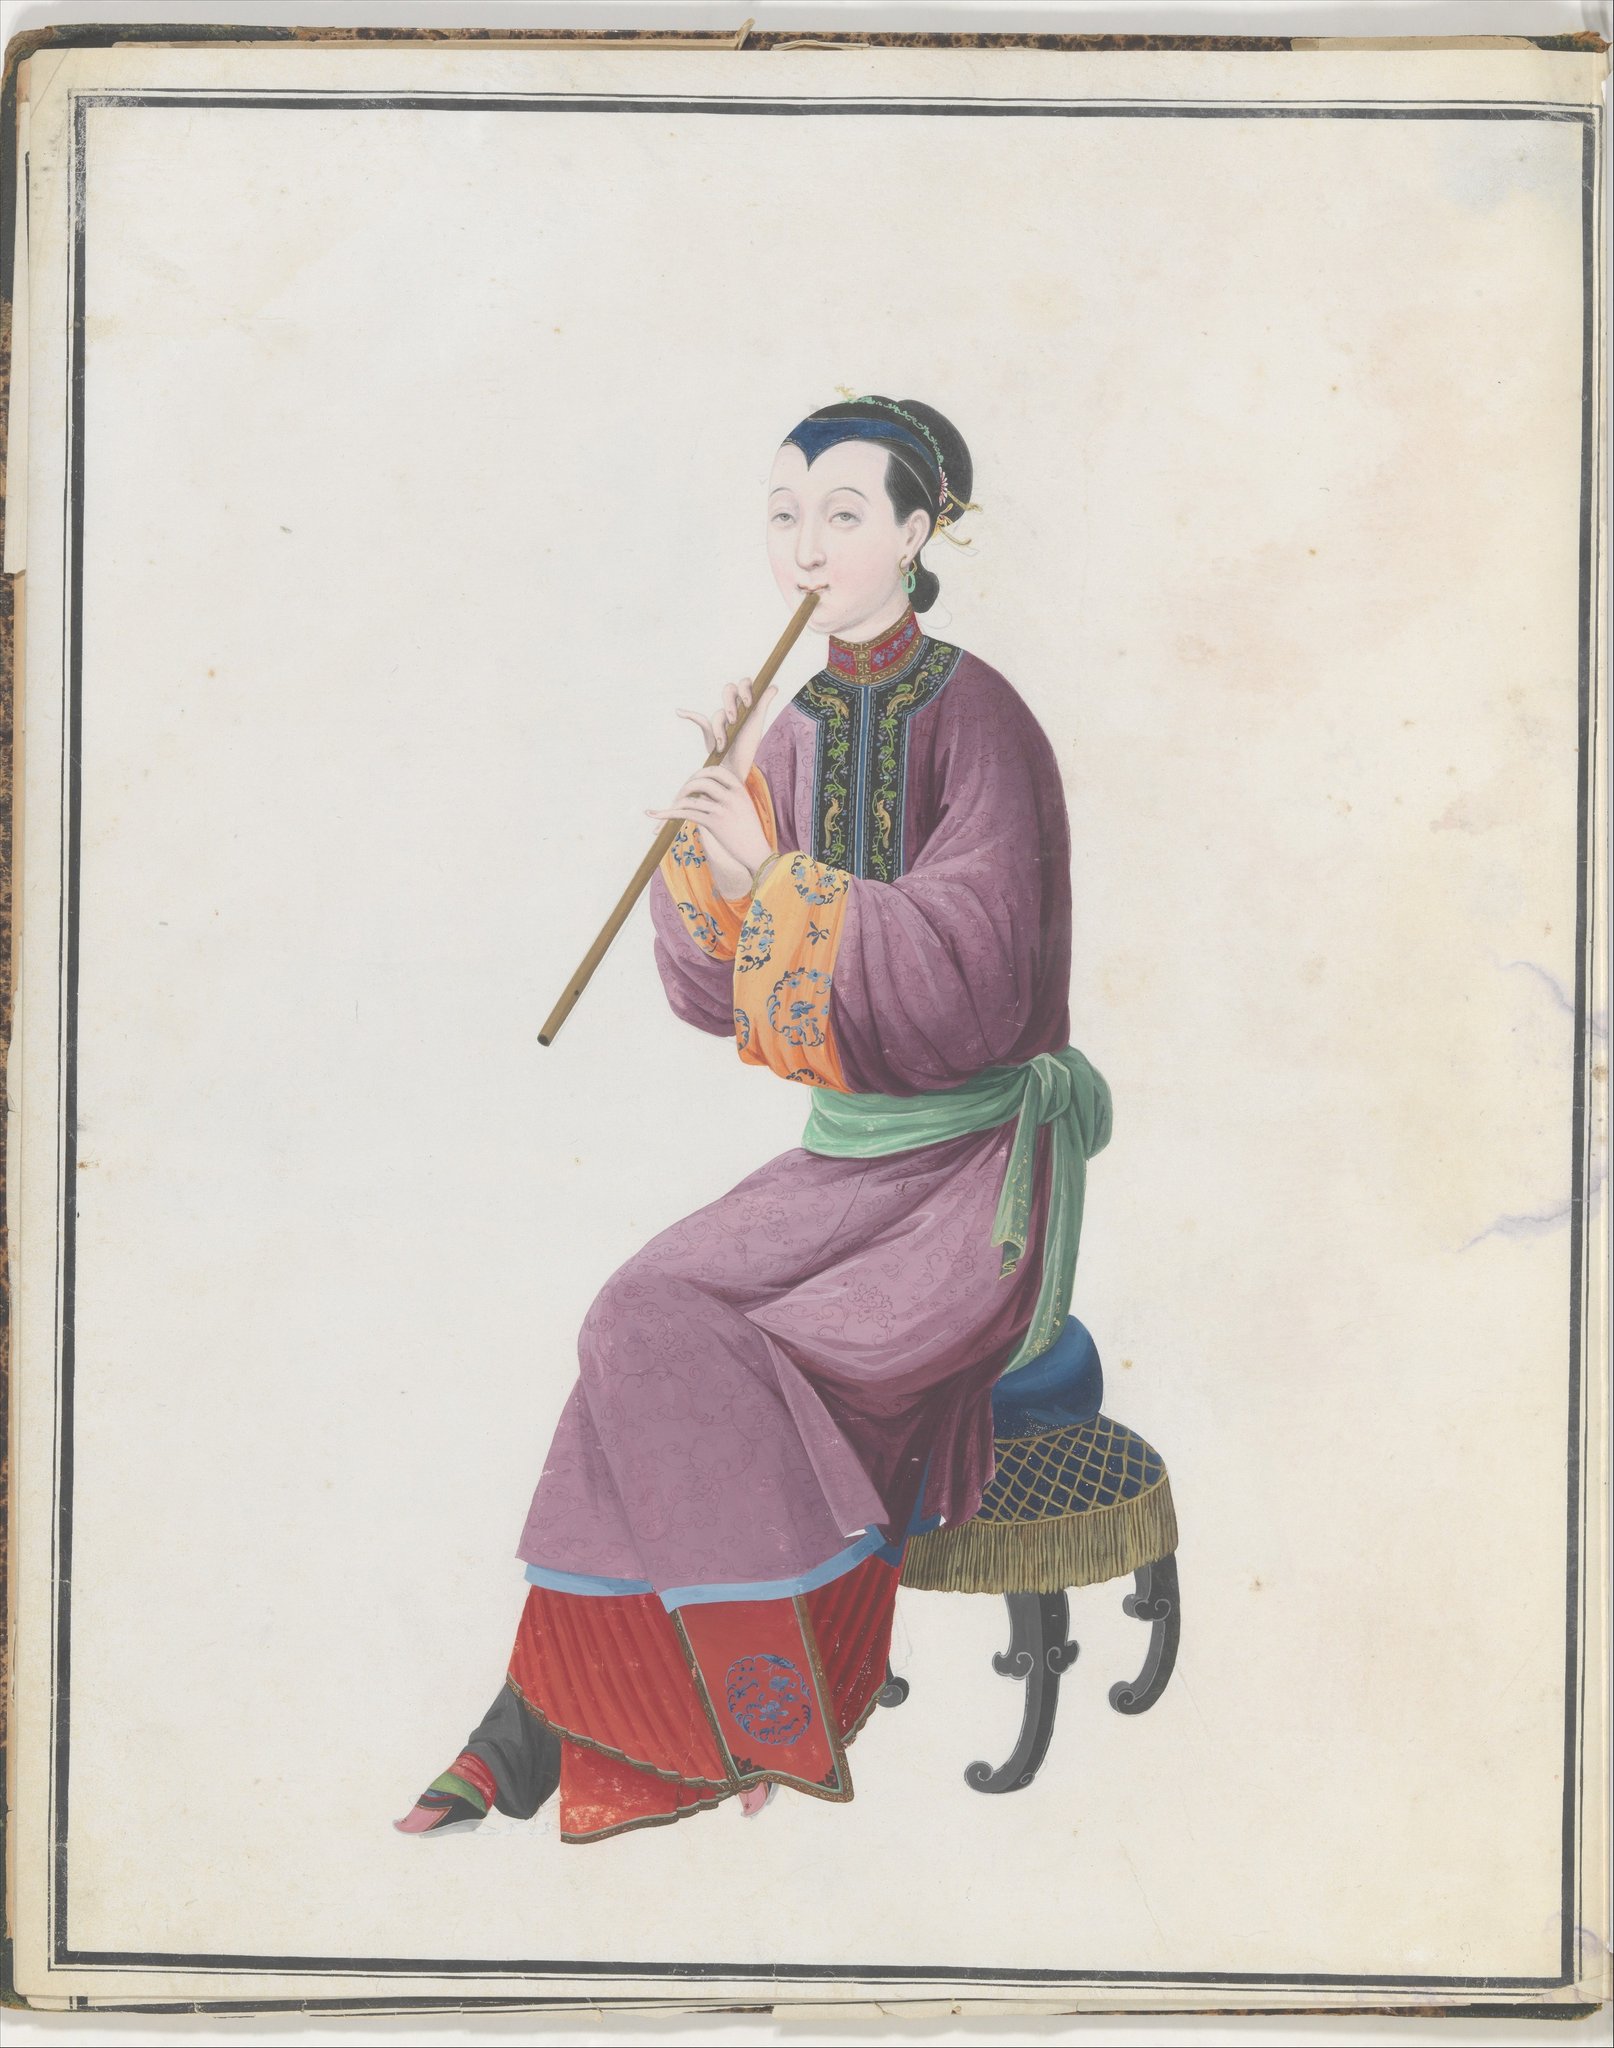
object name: watercolor of musician playing xiao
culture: chinese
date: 1767-1800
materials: paper, watercolor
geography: china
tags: musical instruments,women,musicians